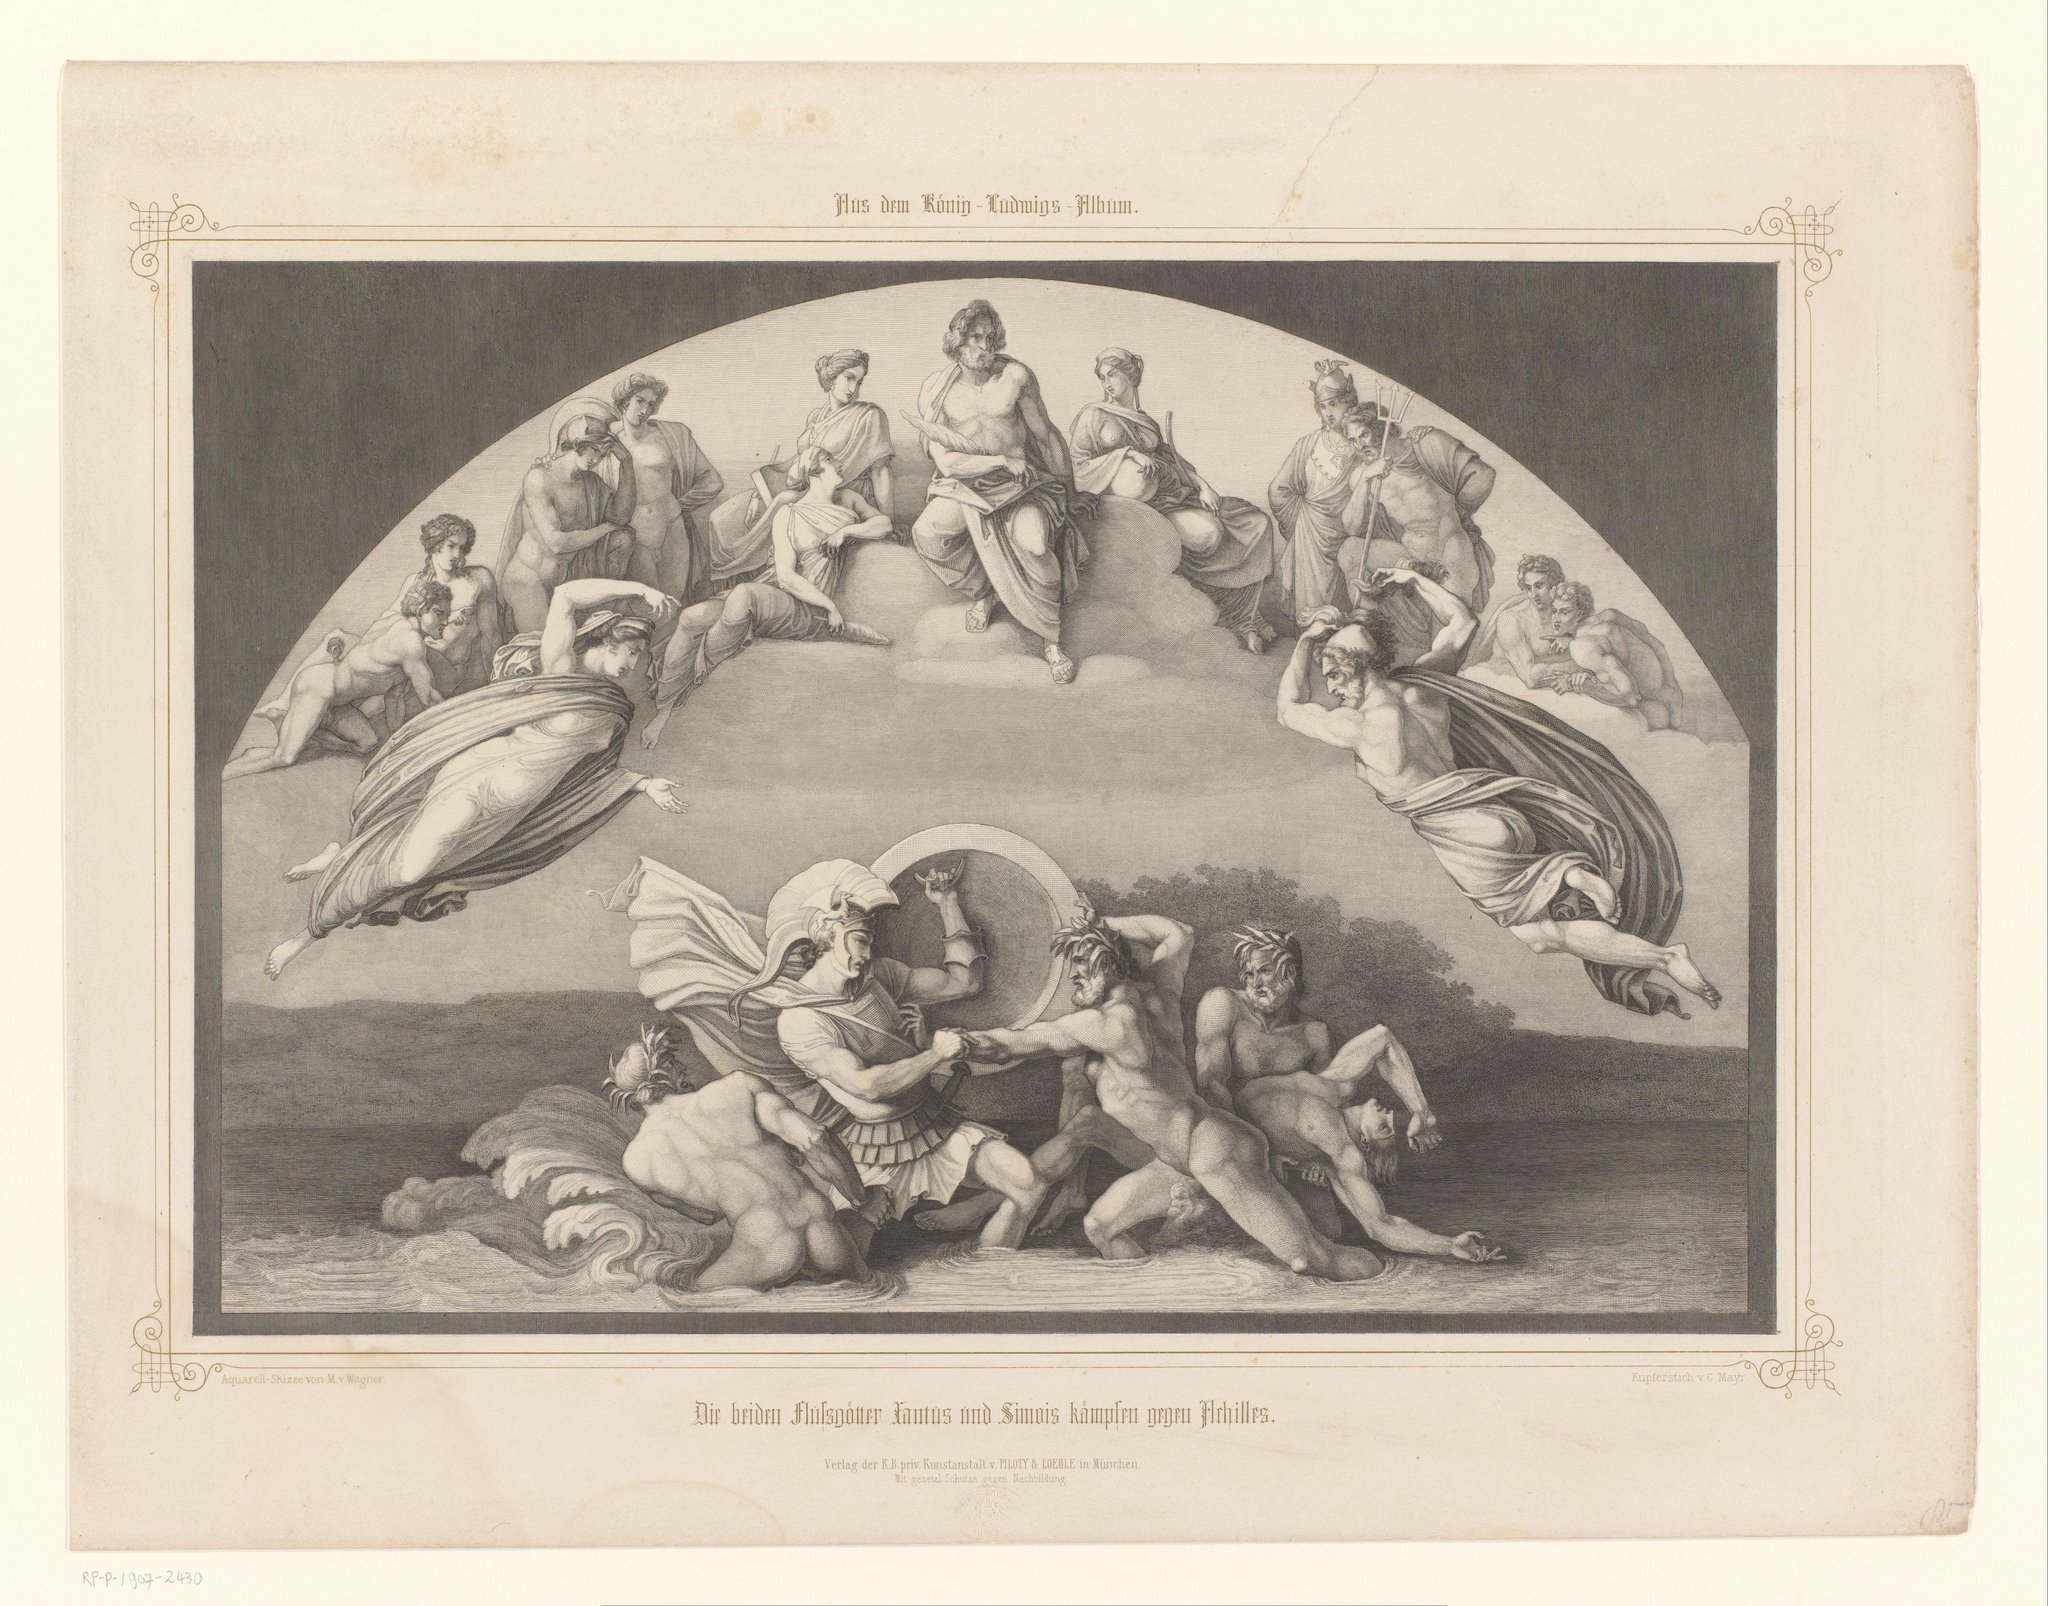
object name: print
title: Achilles in gevecht met de riviergoden Scamander en Simois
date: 1850-1859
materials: paper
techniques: lithograph, engraving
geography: munich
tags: lodewijk i (koning van beieren), achilles fights the river-gods scamander and simois; achilles is assisted by vulcan, who dries up the waters with scorching flames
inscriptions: collector's mark: Lugt 2228, check stamp: ‘Piloty & Loehle München’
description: Prent afkomstig uit de serie 'Album Seiner Majestät des Königs Ludwig I. von Bayern', verschenen in verschillende afleveringen. De prenten gaan terug op het album dat Lodewijk I van Beieren op 9 oktober 1850 kreeg overhandigd van verschillende kunstenaars.